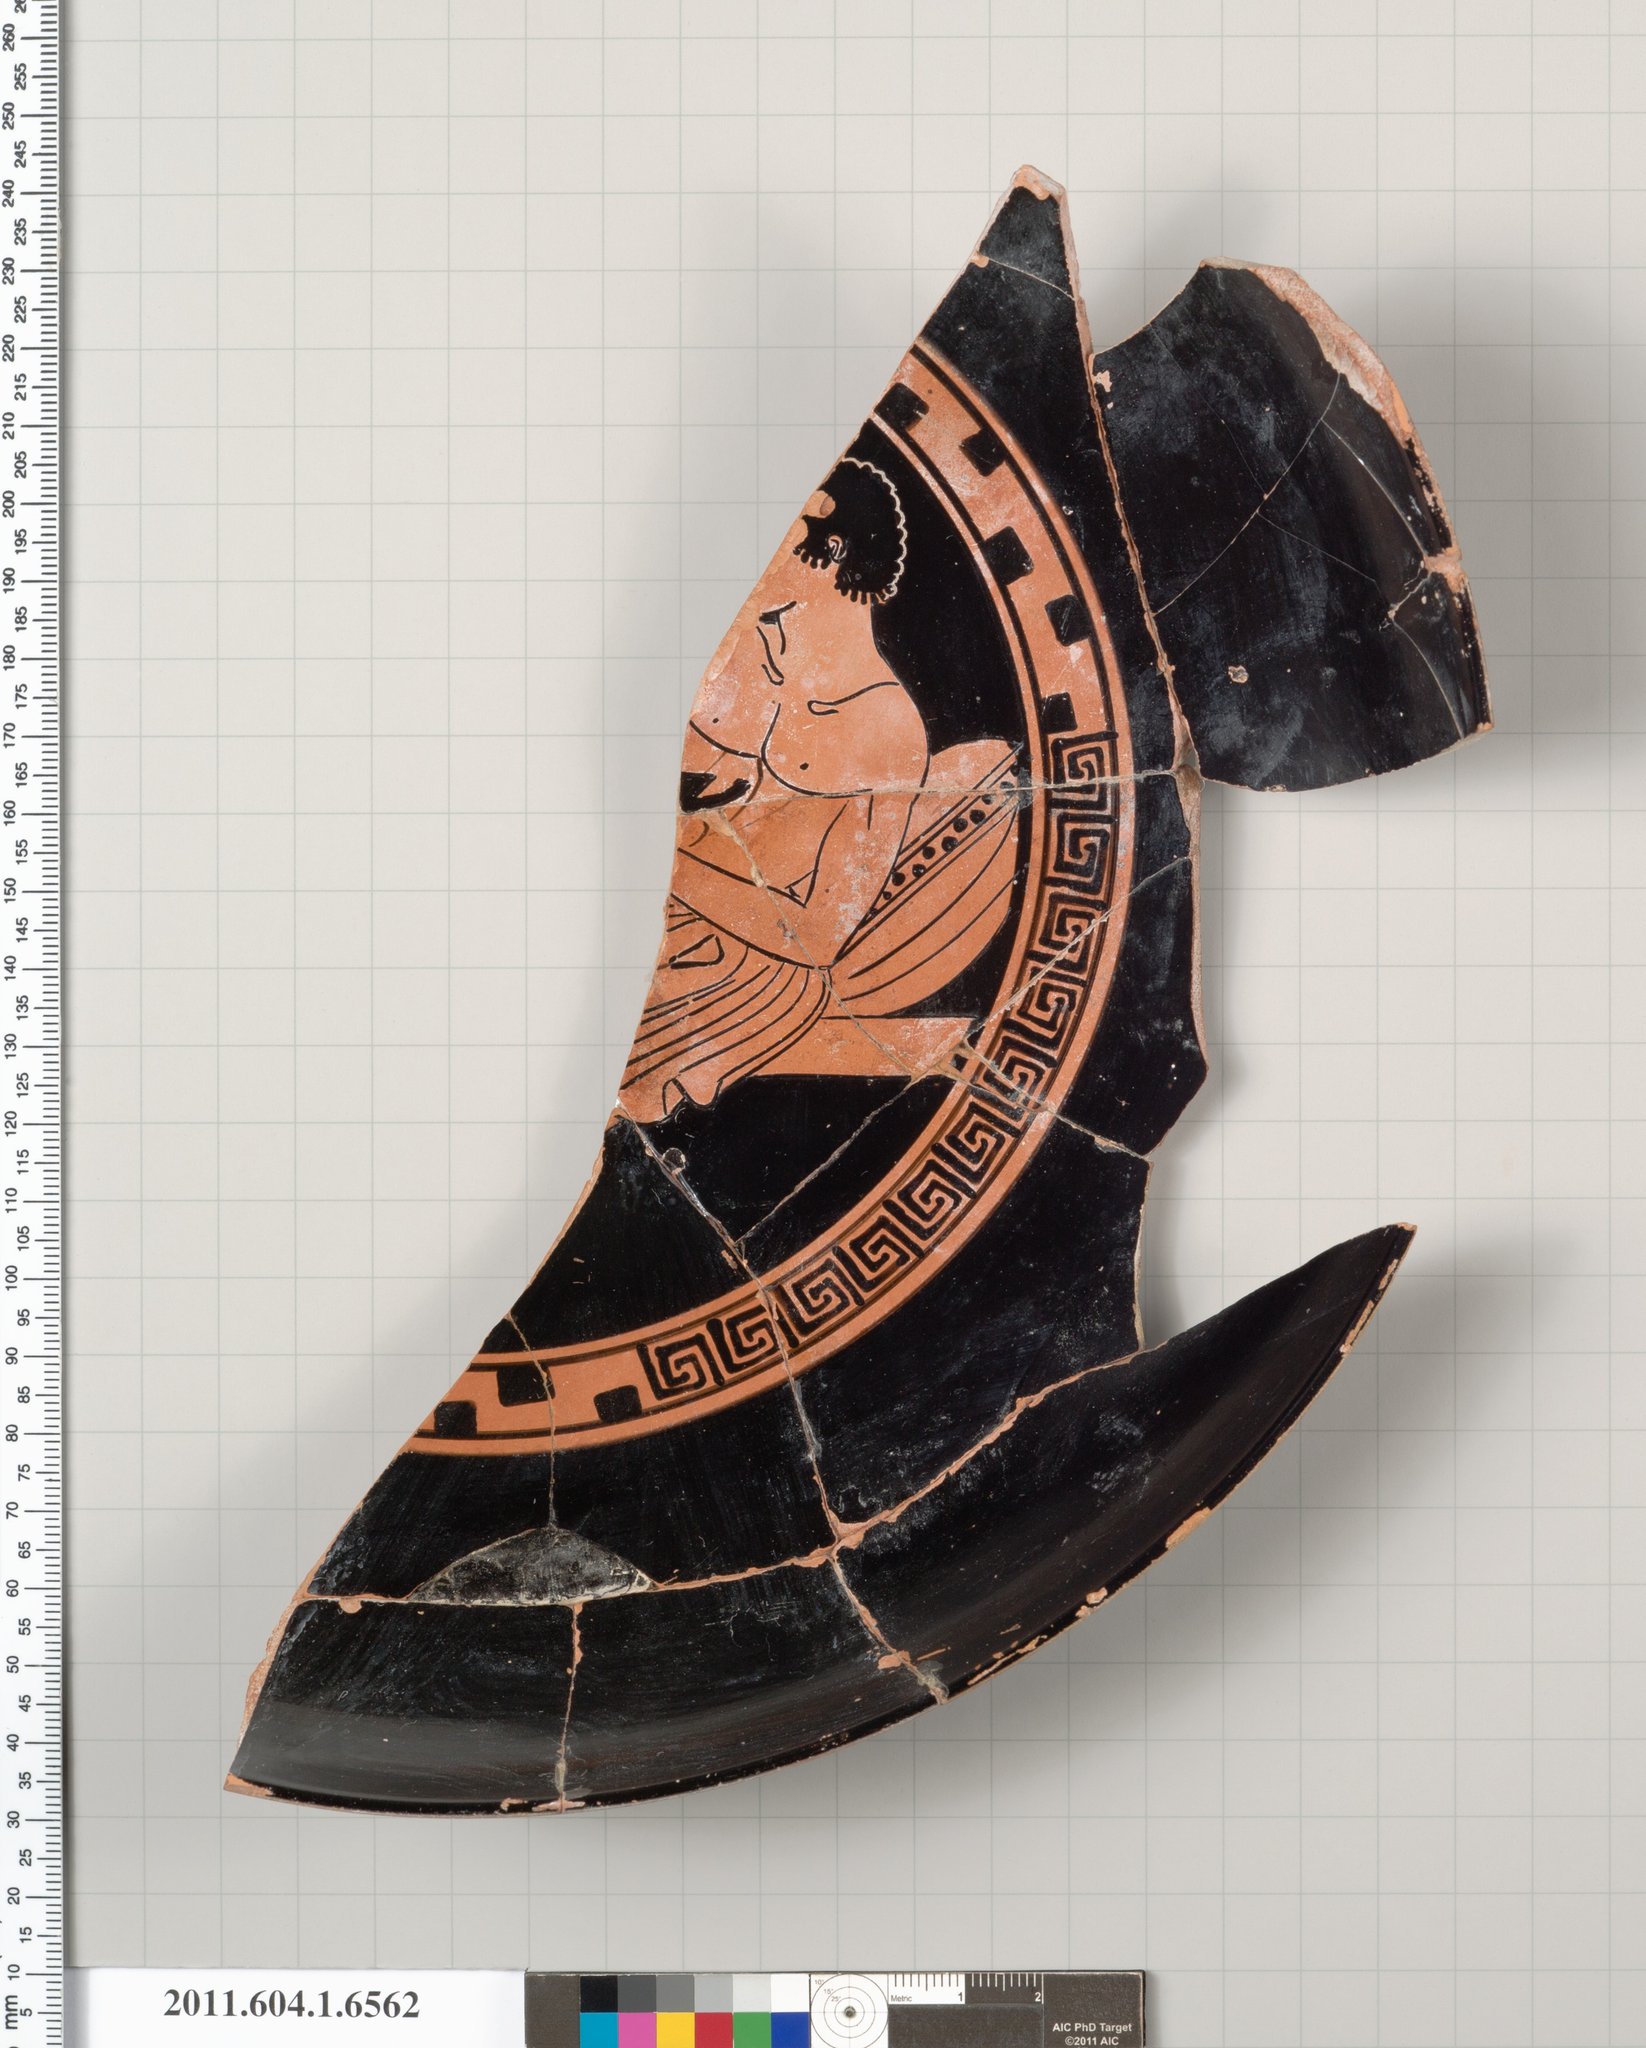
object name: kylix fragment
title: Terracotta fragment of a kylix (drinking cup)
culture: greek, attic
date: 490-480 BCE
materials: terracotta